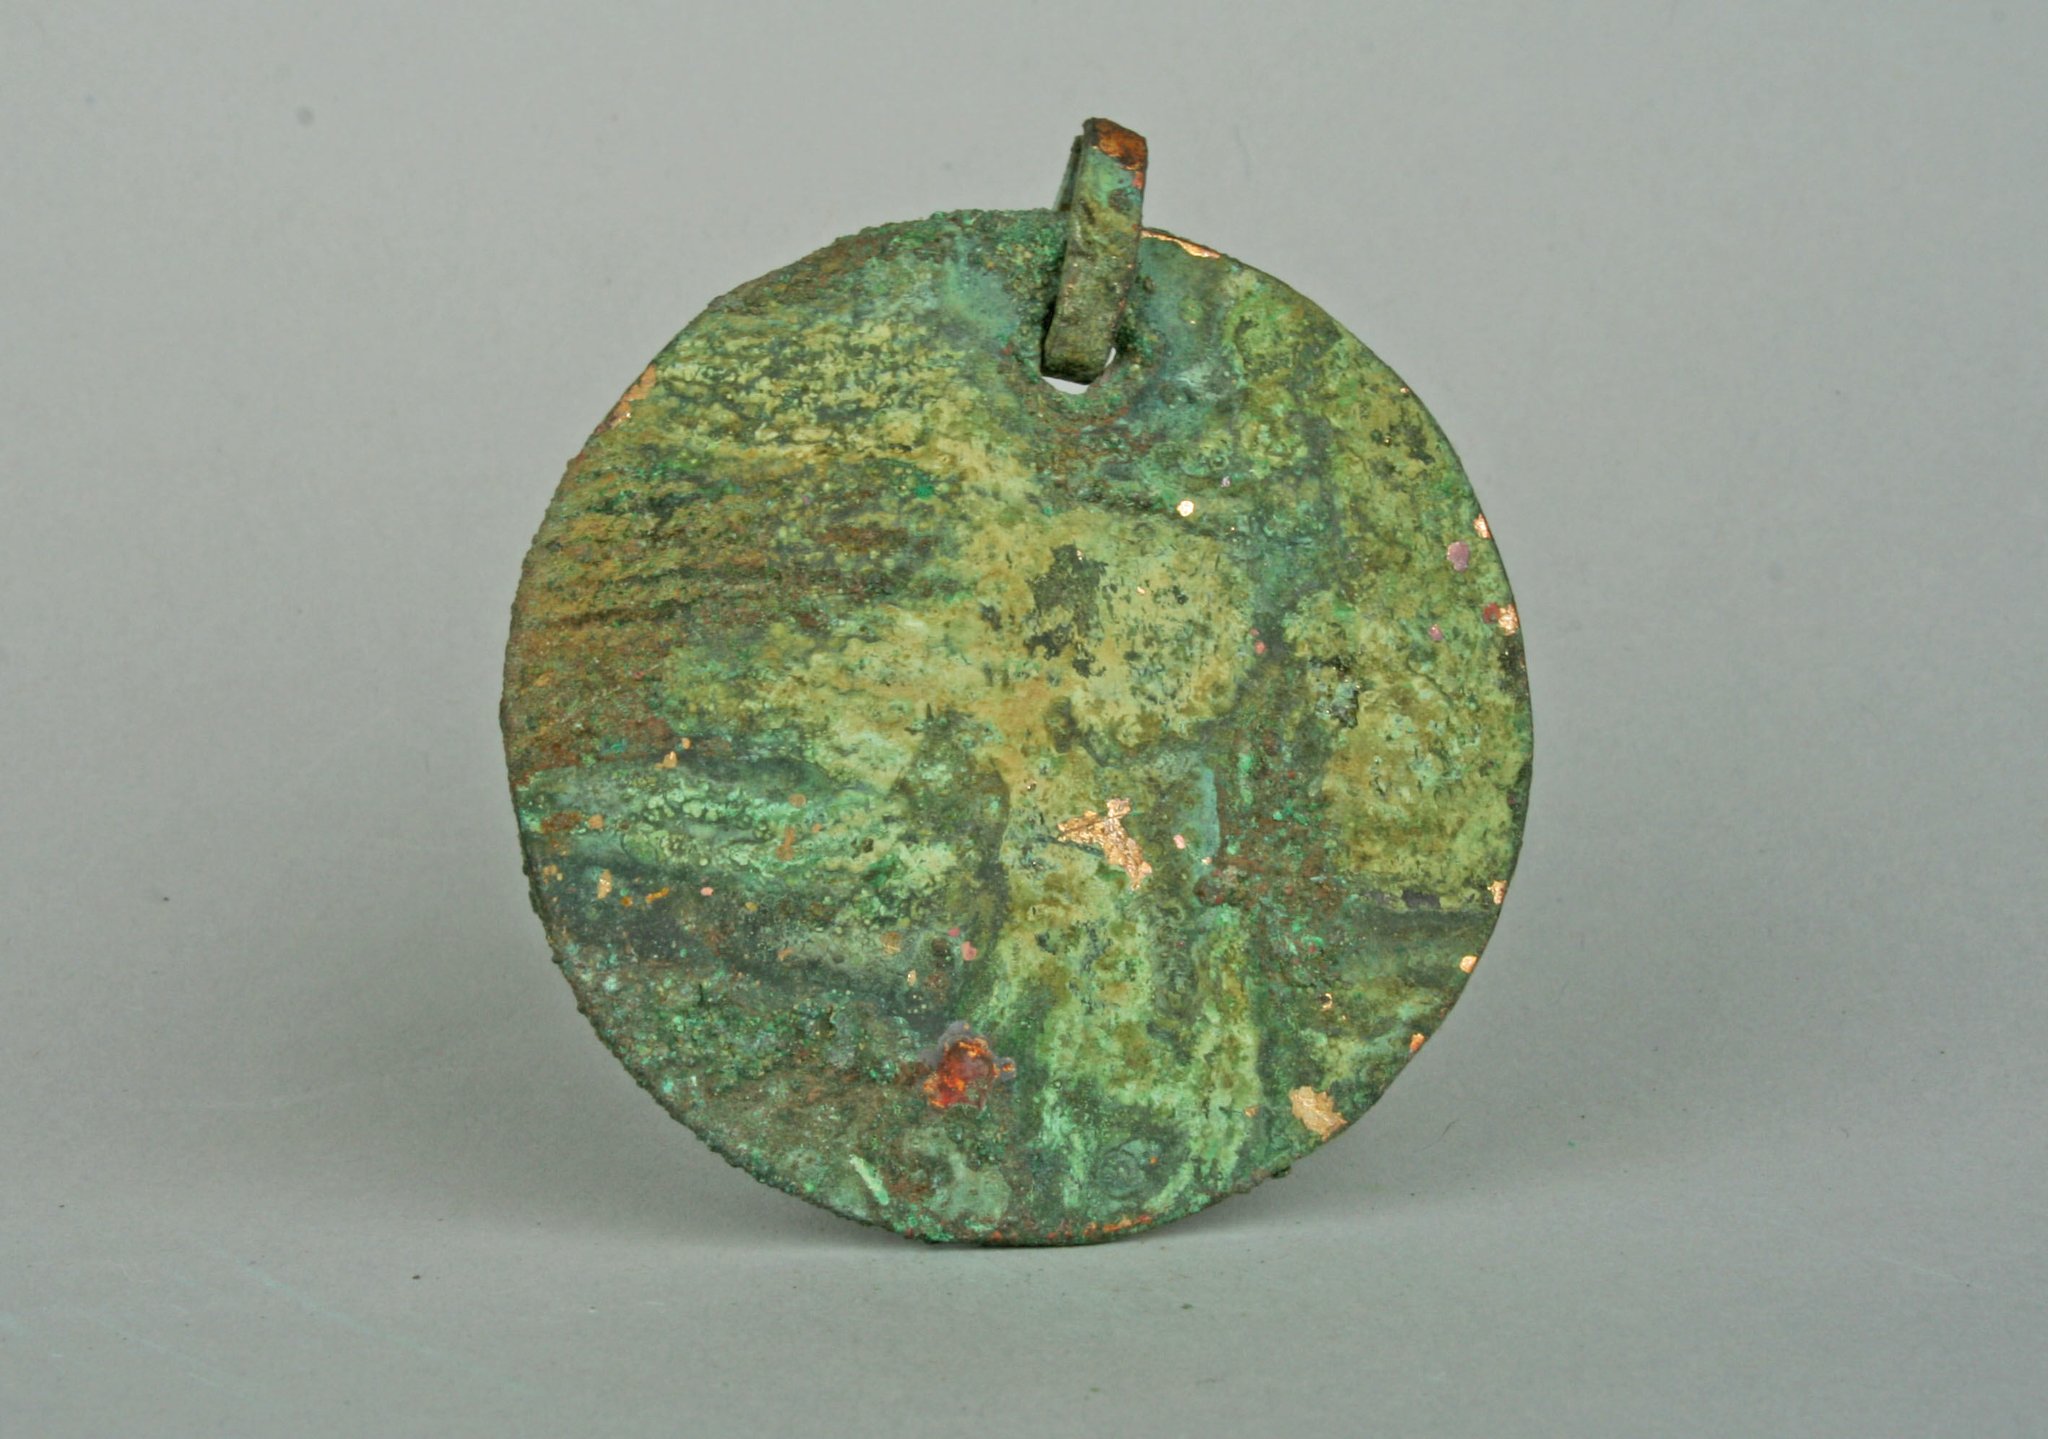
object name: plaque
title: Round Plaque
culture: vicús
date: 300 BCE-200 CE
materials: copper, gilt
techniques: hammering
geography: peru